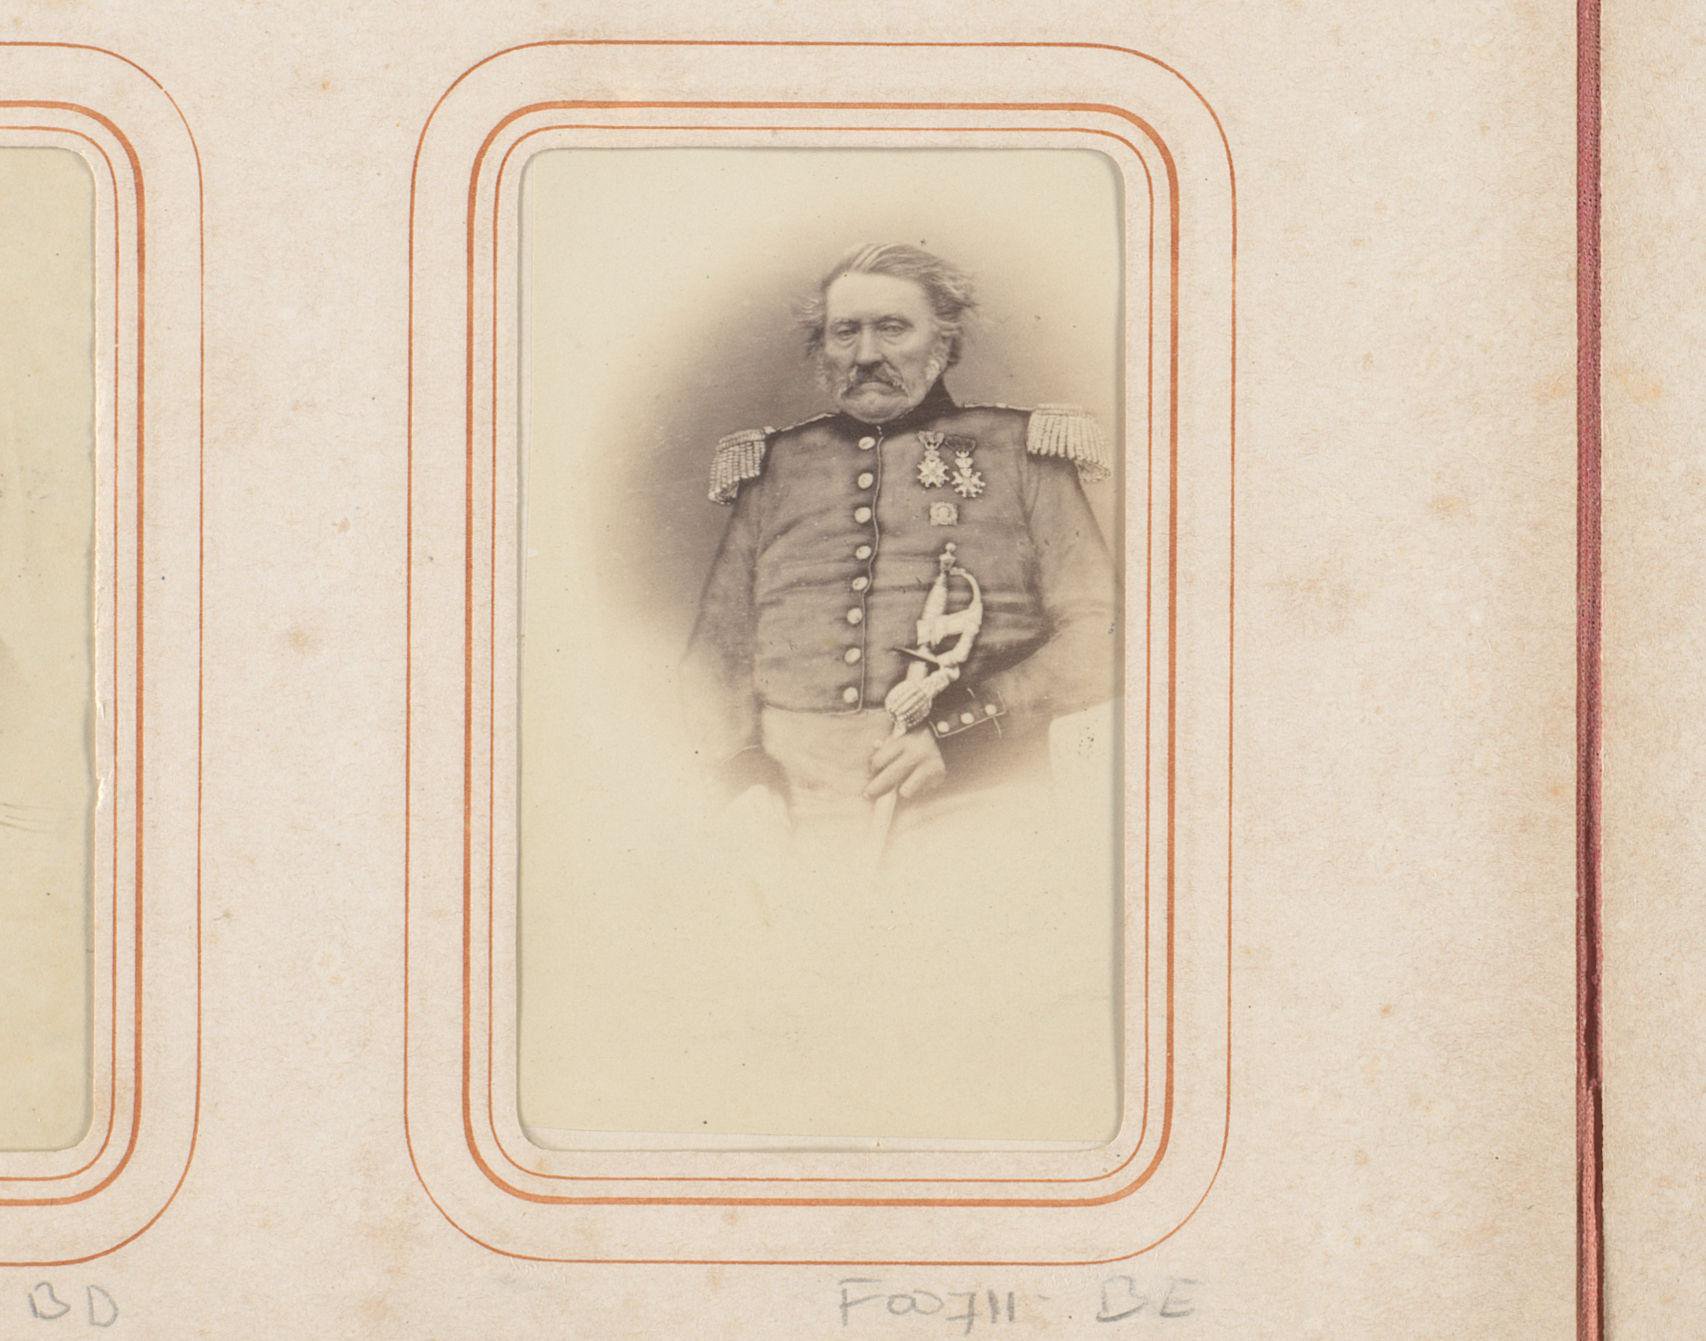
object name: album leaf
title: Portret van een man in militair uniform met medailles en sabel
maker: albert greiner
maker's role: fotograaf, fotostudio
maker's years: 1833-1890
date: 1861-1874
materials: cardboard, photographic support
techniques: albumen print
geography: amsterdam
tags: historical persons, medals and other marks of military honour, (military) uniforms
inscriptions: inscription: ‘A. Greiner/ Photograf/ Nieuwendijk L.87/ Amsterdam’